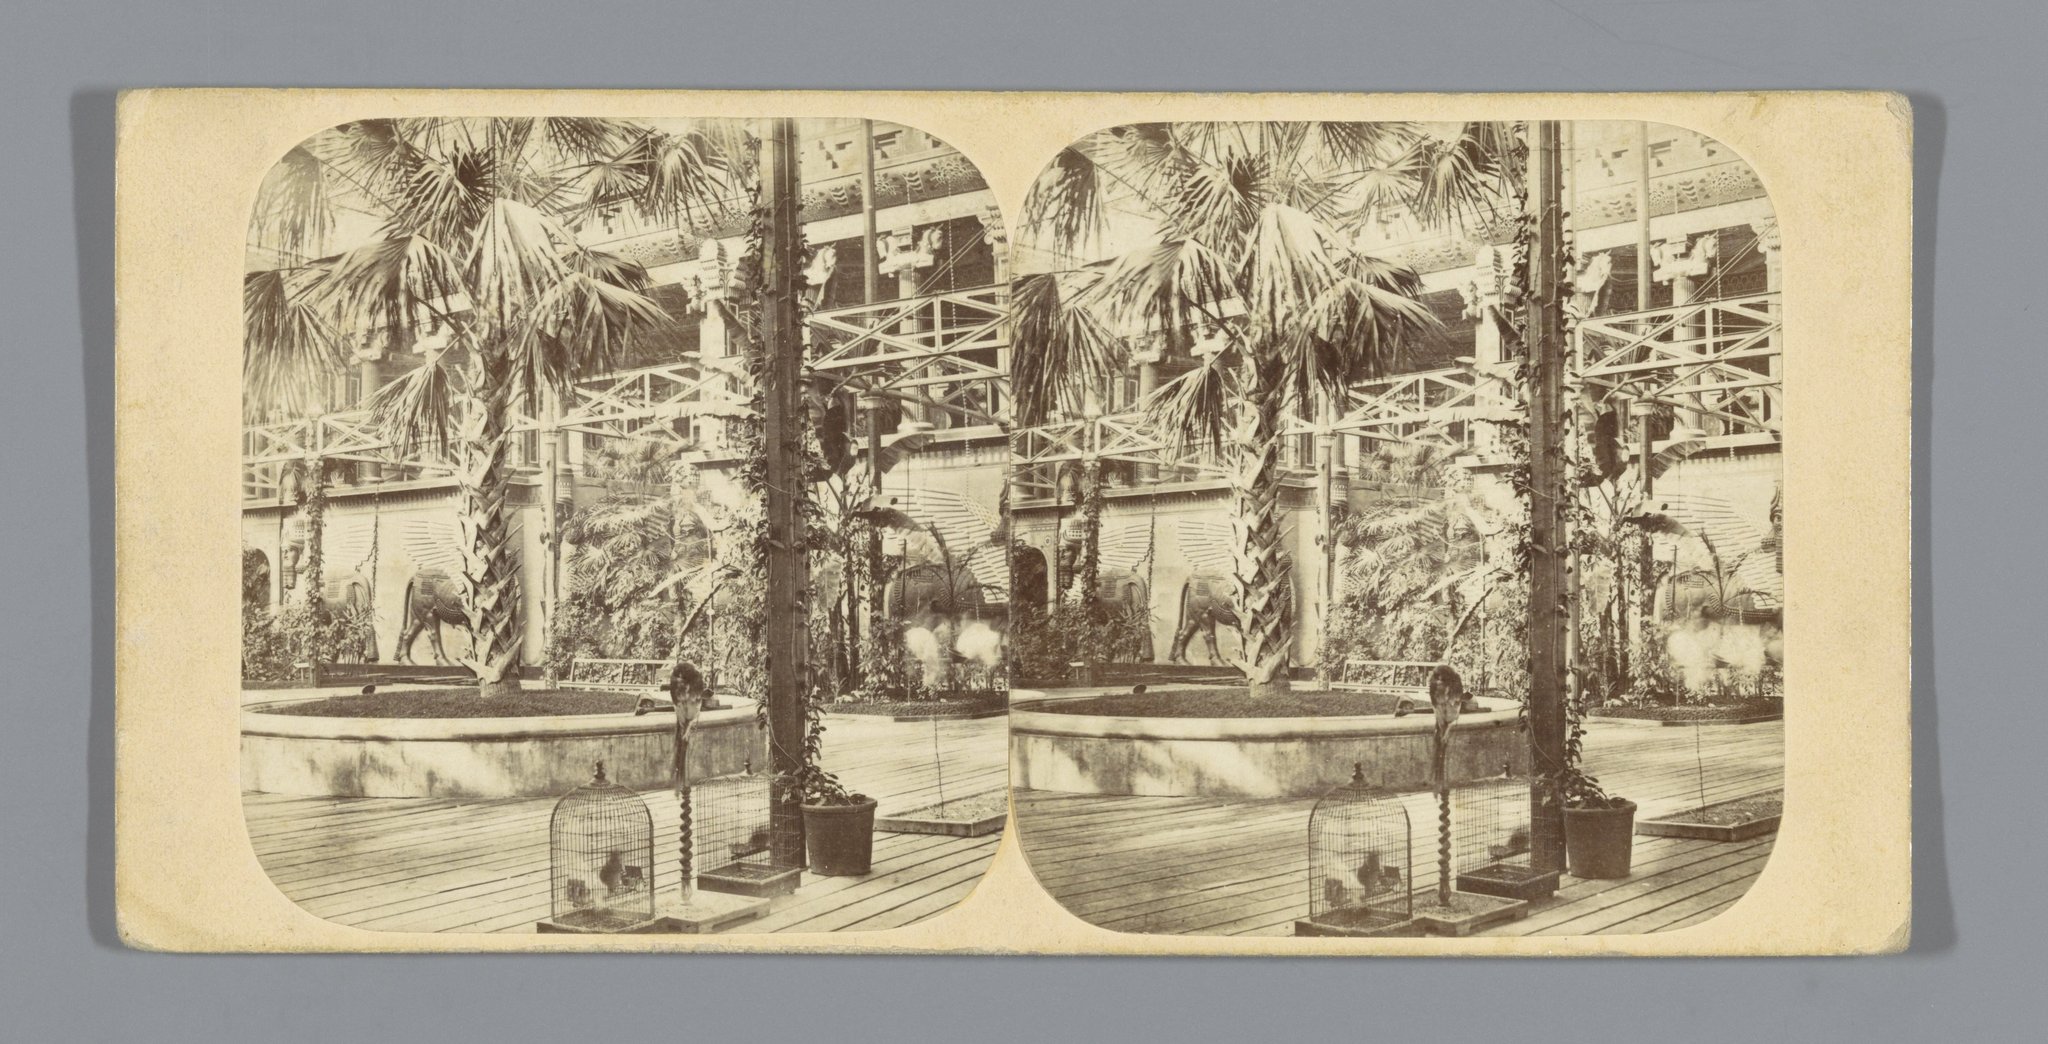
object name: stereograph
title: Crystal Palace. The Great Palm, and Nineveh Court, Tropical Department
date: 1854-1859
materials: cardboard, photographic support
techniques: albumen print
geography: crystal palace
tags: trees: palm-tree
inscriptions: name: ‘Kunsthandlung Joh. Heinrigs in Cöln Hochstrasse 152. (...)’, number: ‘43.’, number: ‘38’